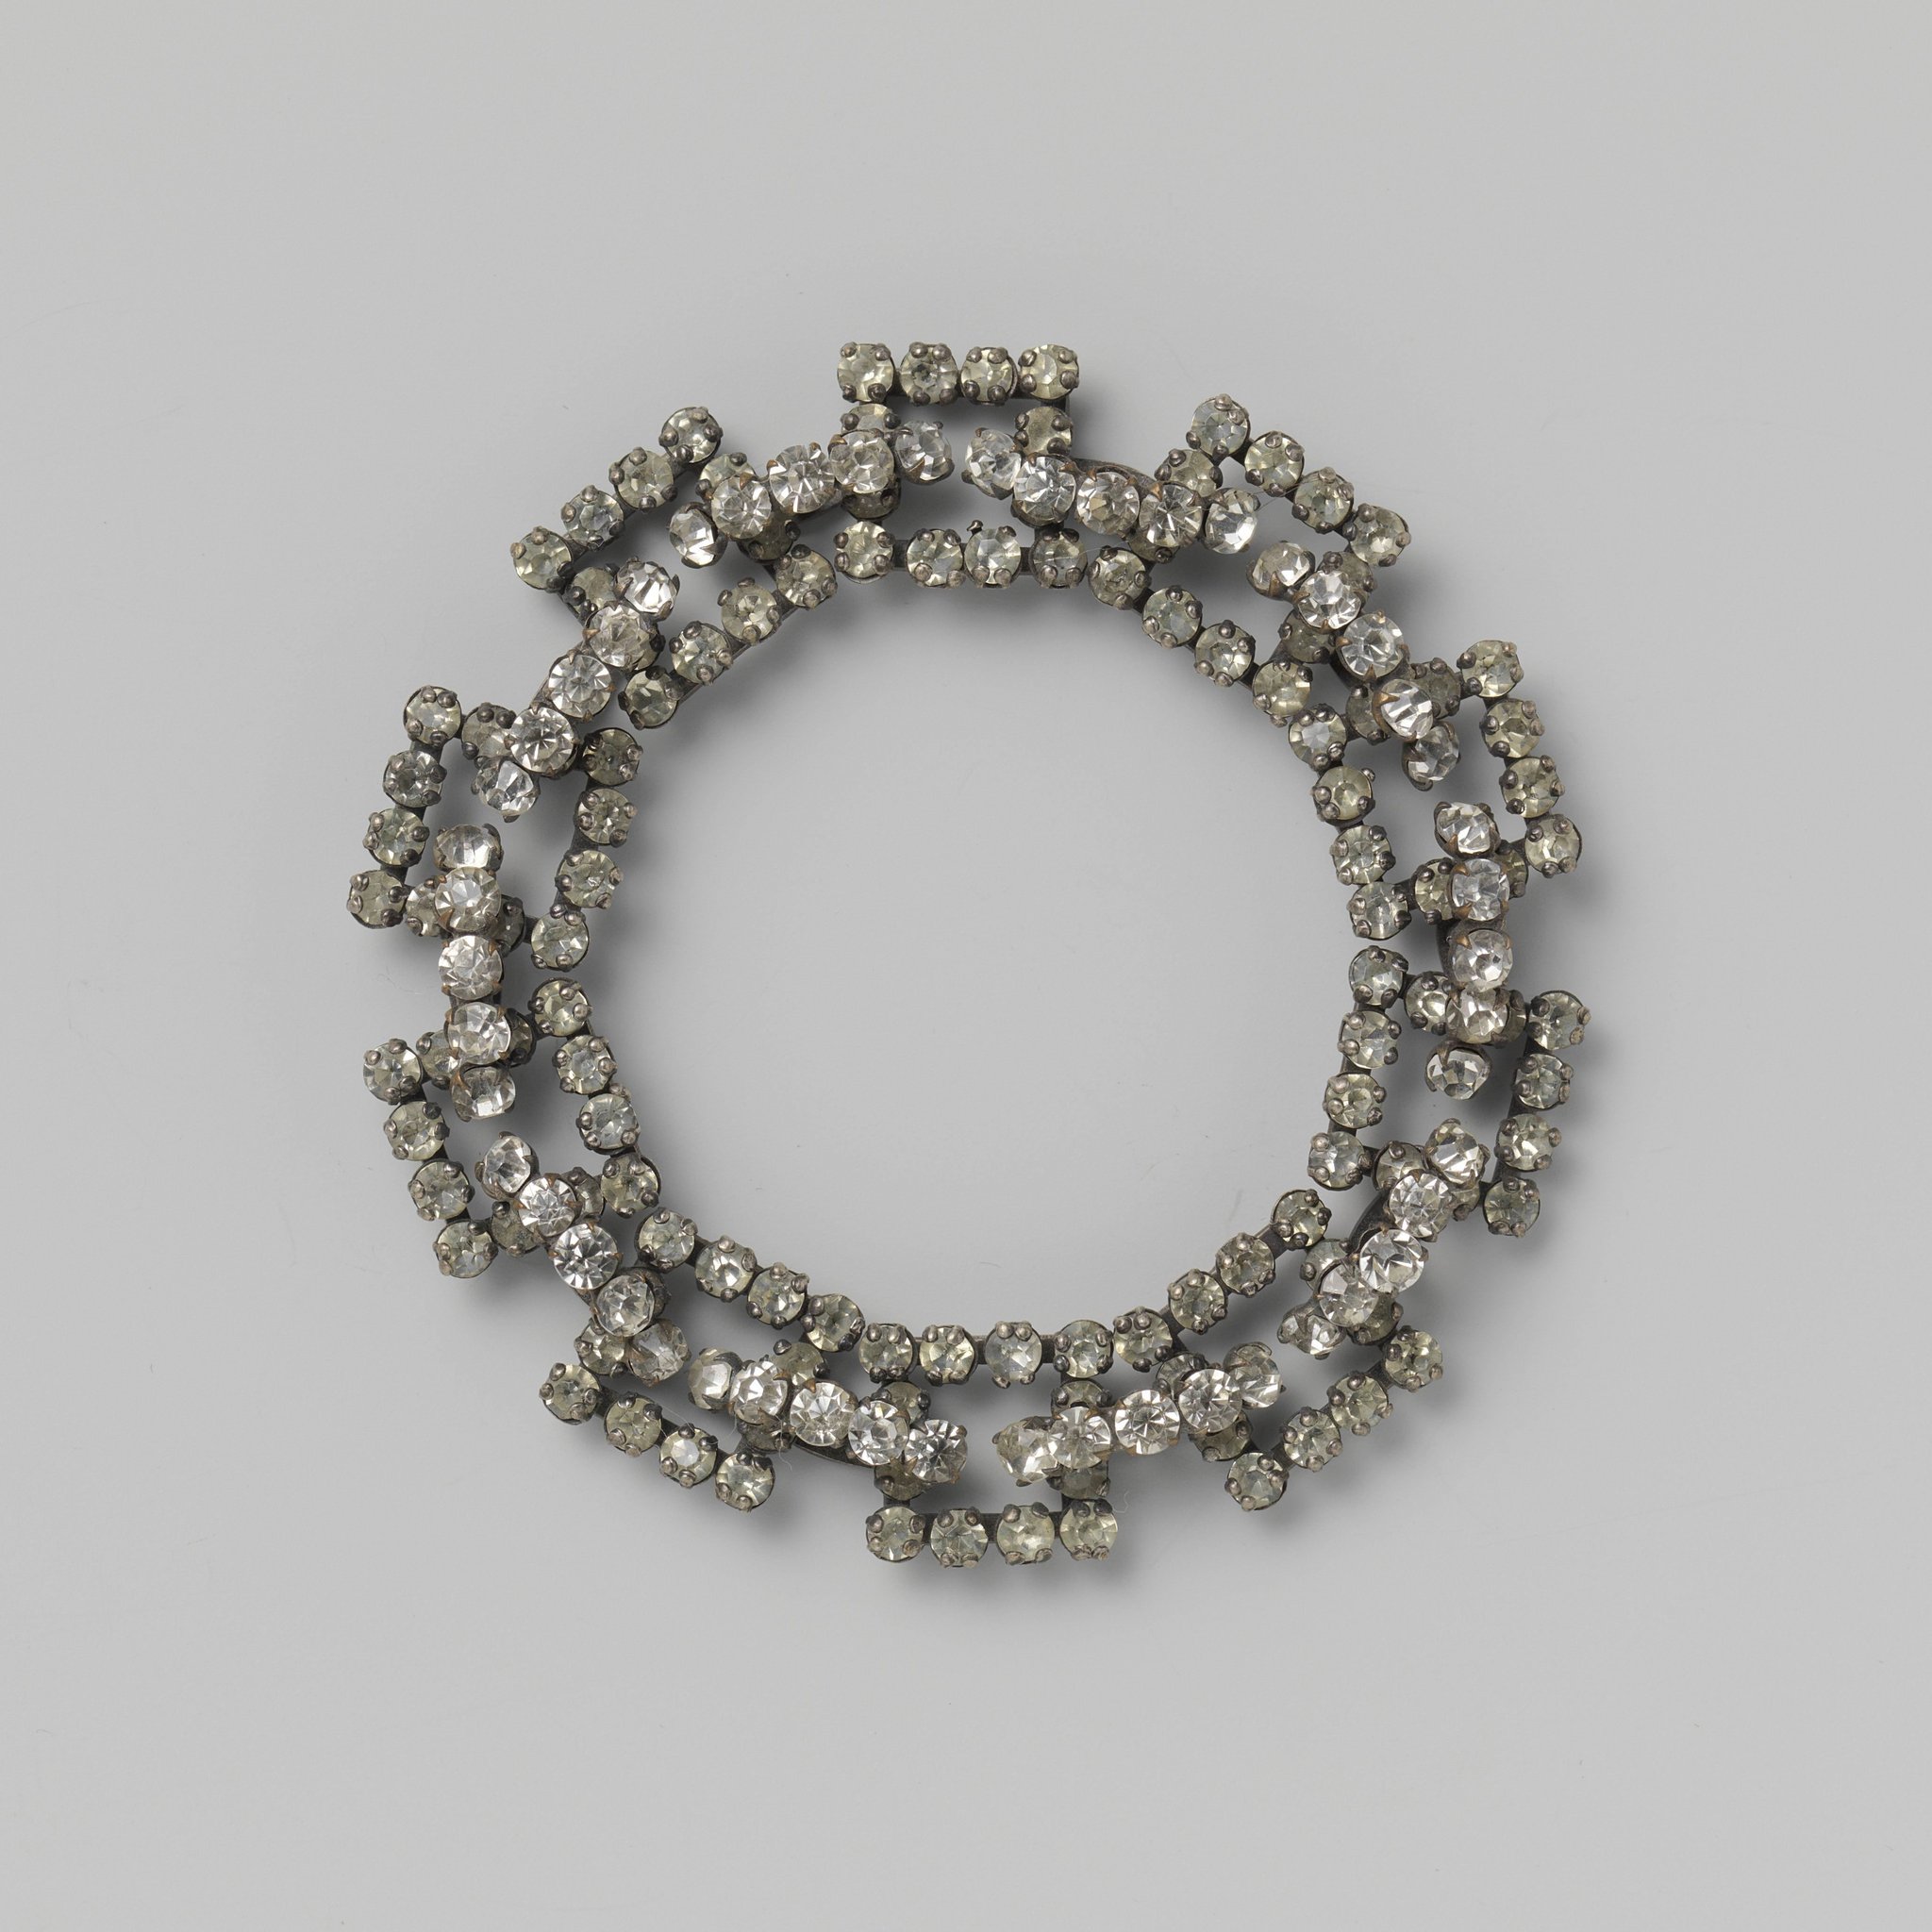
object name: hair ornament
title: Gesp, broche of haartooi van zilverkleurig metaal bezet met stras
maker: Anonymous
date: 1900-1920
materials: metal, paste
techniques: forging, grinding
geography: france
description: Gesp, broche of haartooi van zilverkleurig metaal bezet met stras. Rond model met een schakeling van straalsgewijs geplaatste vierkanten bezet met stras. De vierkanten zijn aaneengeschakeld met bogen van telkens vijf strasstenen die tesamen een middencirkel vormen door de vierkanten.